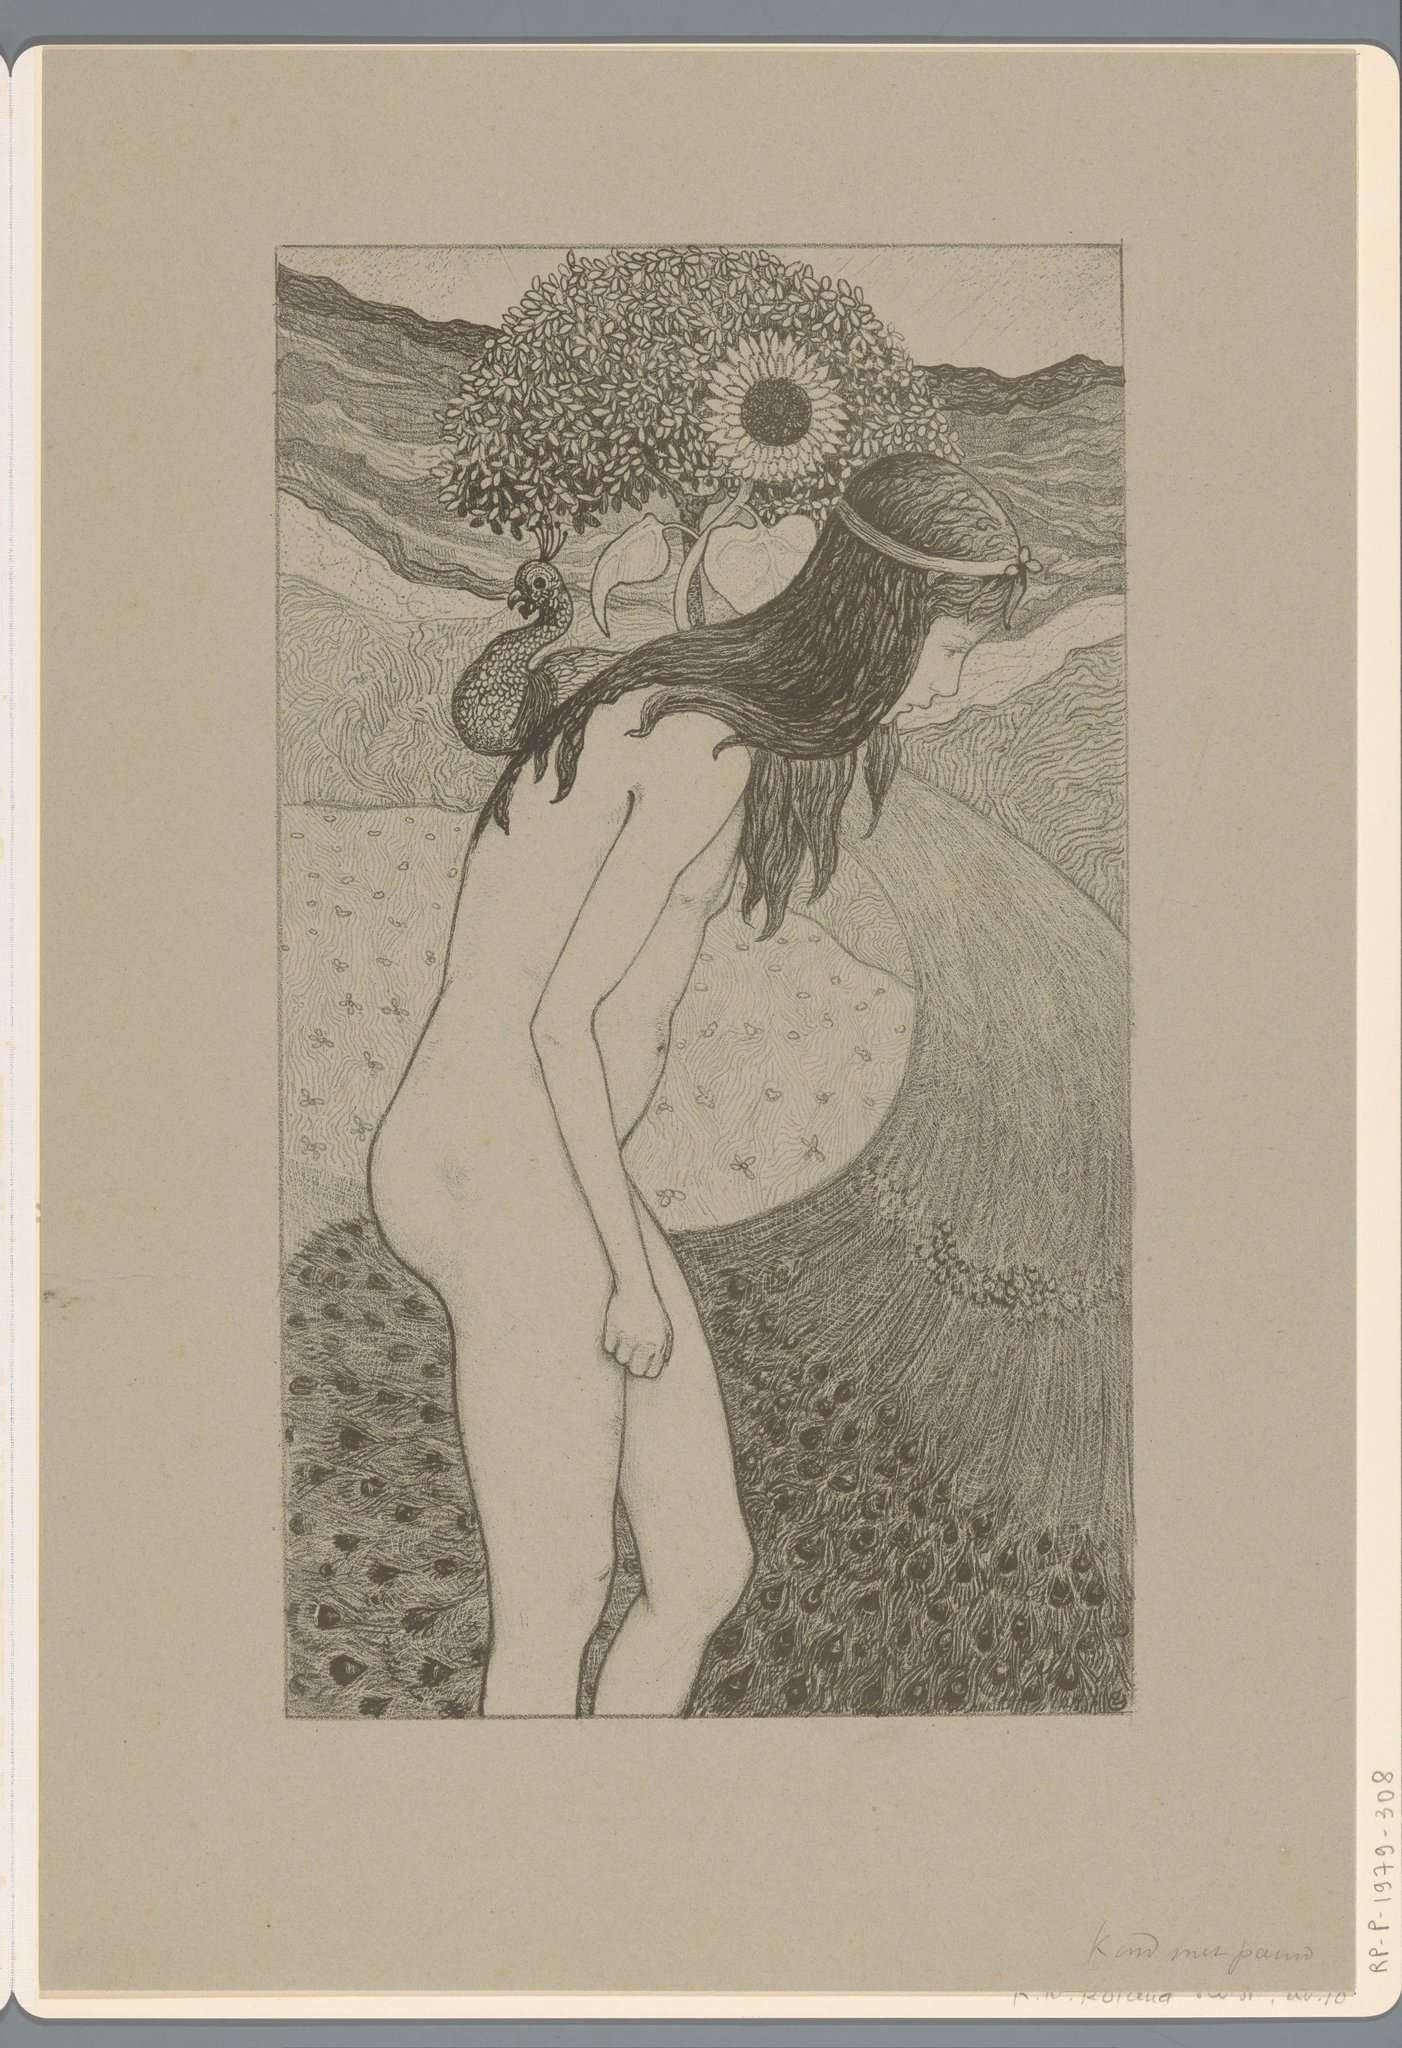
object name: print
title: Kind met pauw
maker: richard nicolaüs roland holst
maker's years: 1868-1938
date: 1892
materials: paper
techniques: lithograph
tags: low hill country, trees, flowers: sunflower, (showing oneself) undressed, quasi-nude, child, ornamental birds: peacock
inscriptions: collector's mark: Lugt 2228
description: Een naakt, staand kind in een heuvellandschap. Op de schouder van het kind zit een pauw. Achter het kind en de pauw groeien een zonnebloem en een boom.